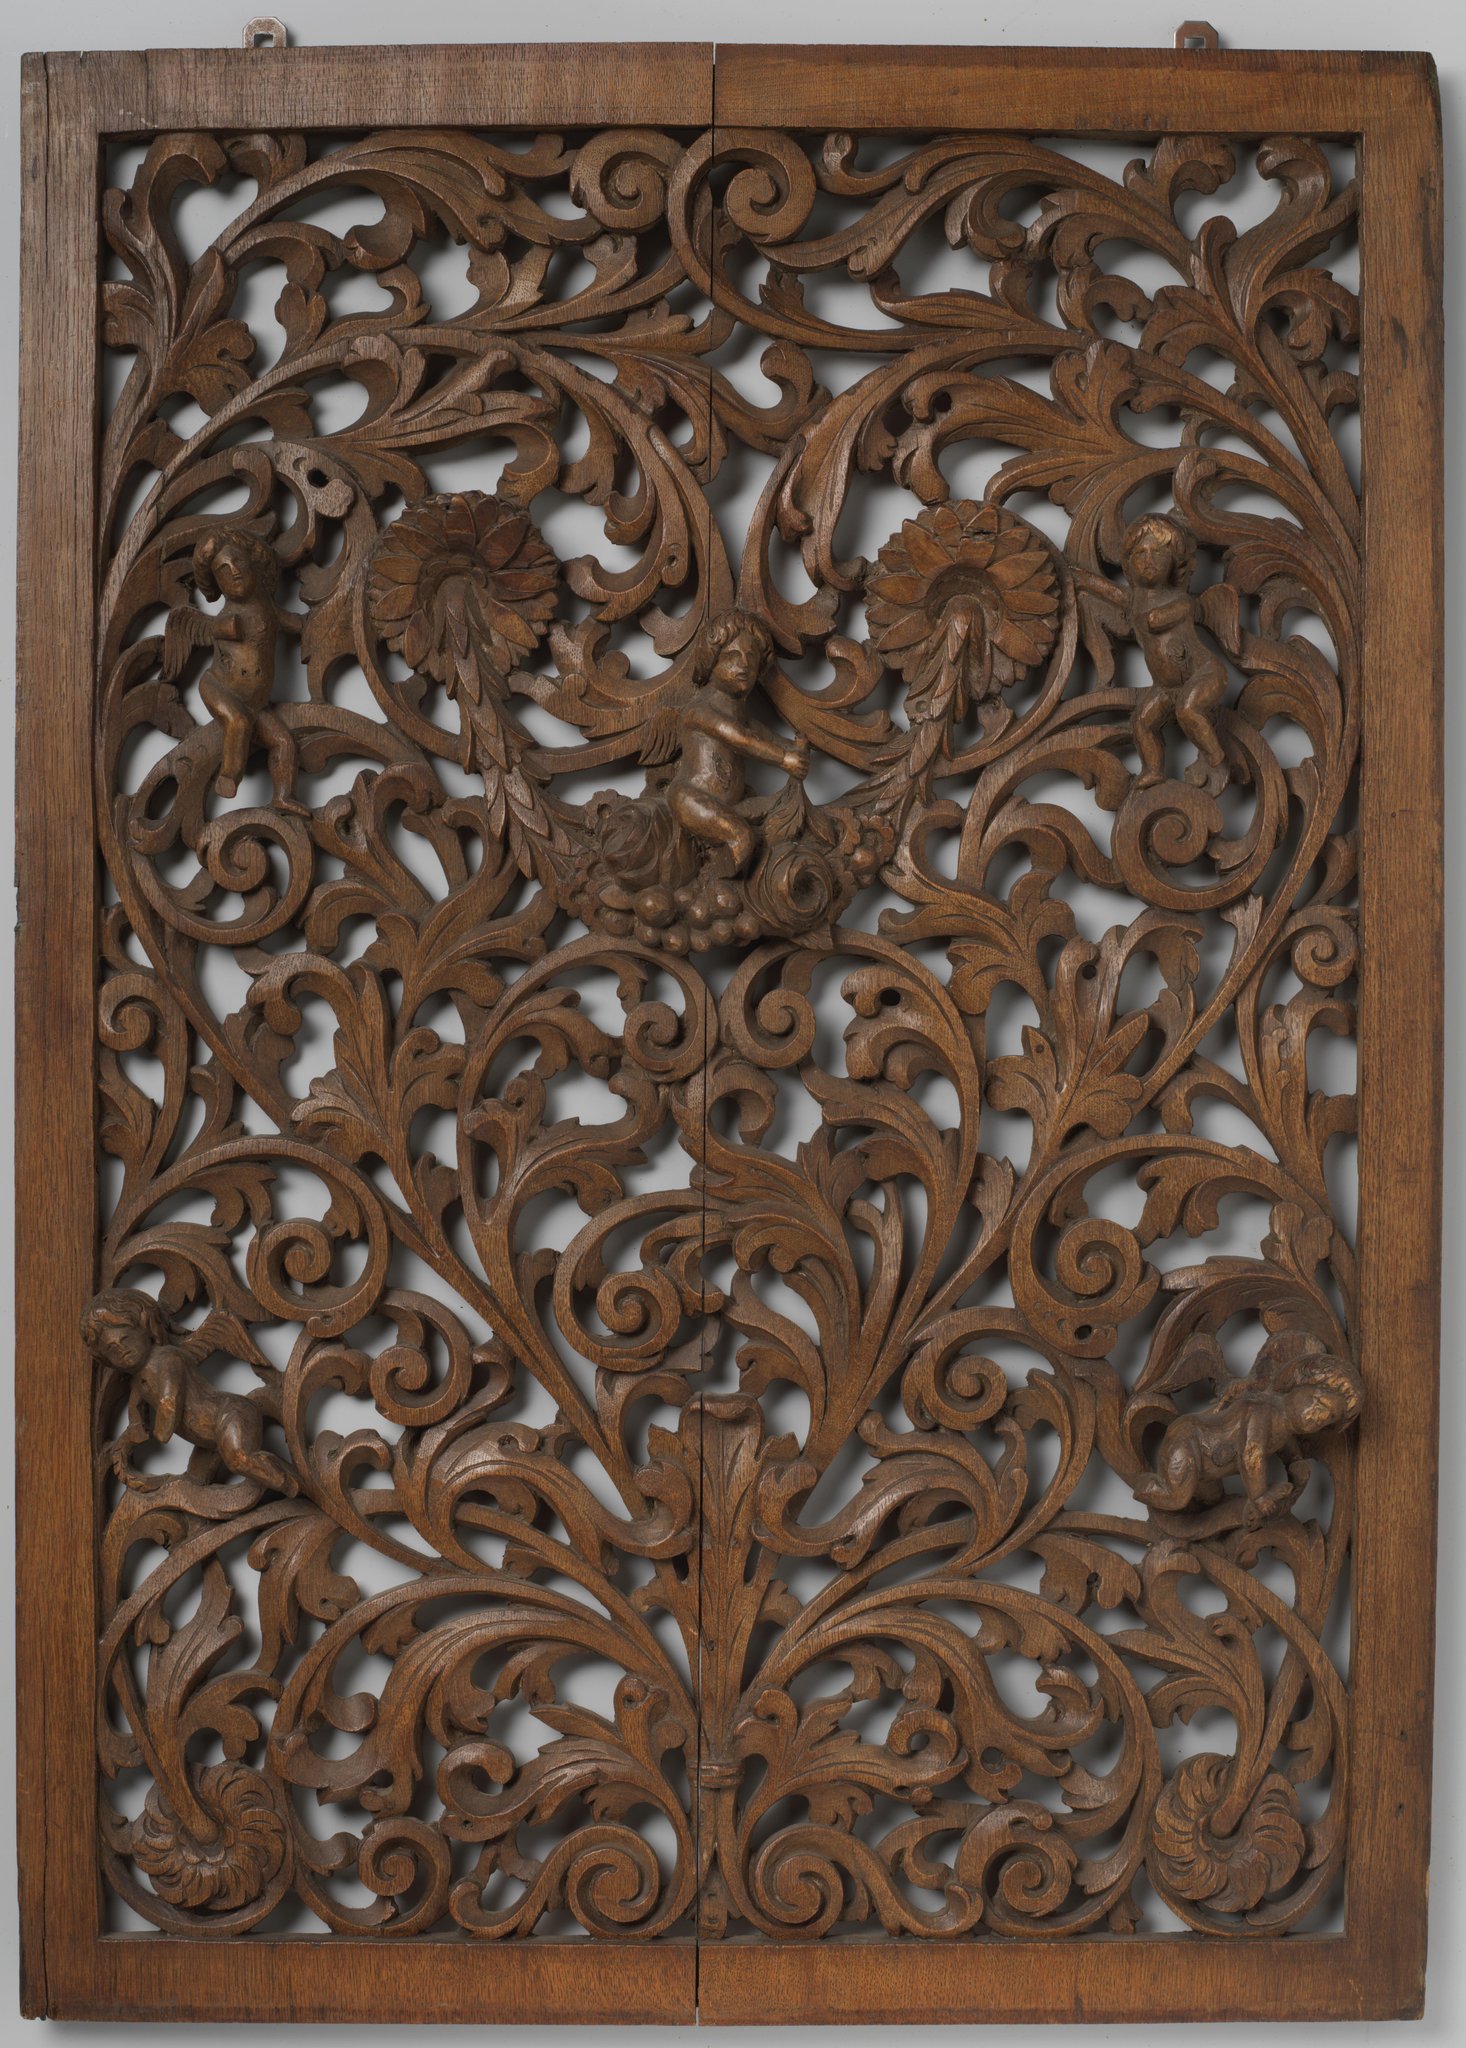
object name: furniture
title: Paneel met opengewerkt symmetrisch ornament van acanthusranken met bloemen en putti en in het midden een adelaar en putto op festoen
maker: Anonymous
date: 1650-1700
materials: wood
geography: northern netherlands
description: Twee deurpanelen van notenhout in een eikenhouten, oorspronkelijk gepolichromeerd, raam. De deurtjes vertonen opengewerkte symmetrische acanthusranken met bloemen en putti, die op hoorns blazen, vruchtentrossen dragen of bloemkransen houden; in het midden een zittende adelaar en putto op een festoen. Horend bij twee panelen (inv.nr. BK-KOG-594-B) en een fries (BK-KOG-594-C). Het geheel is waarschijnlijk van een kast of een betimmering afkomstig.